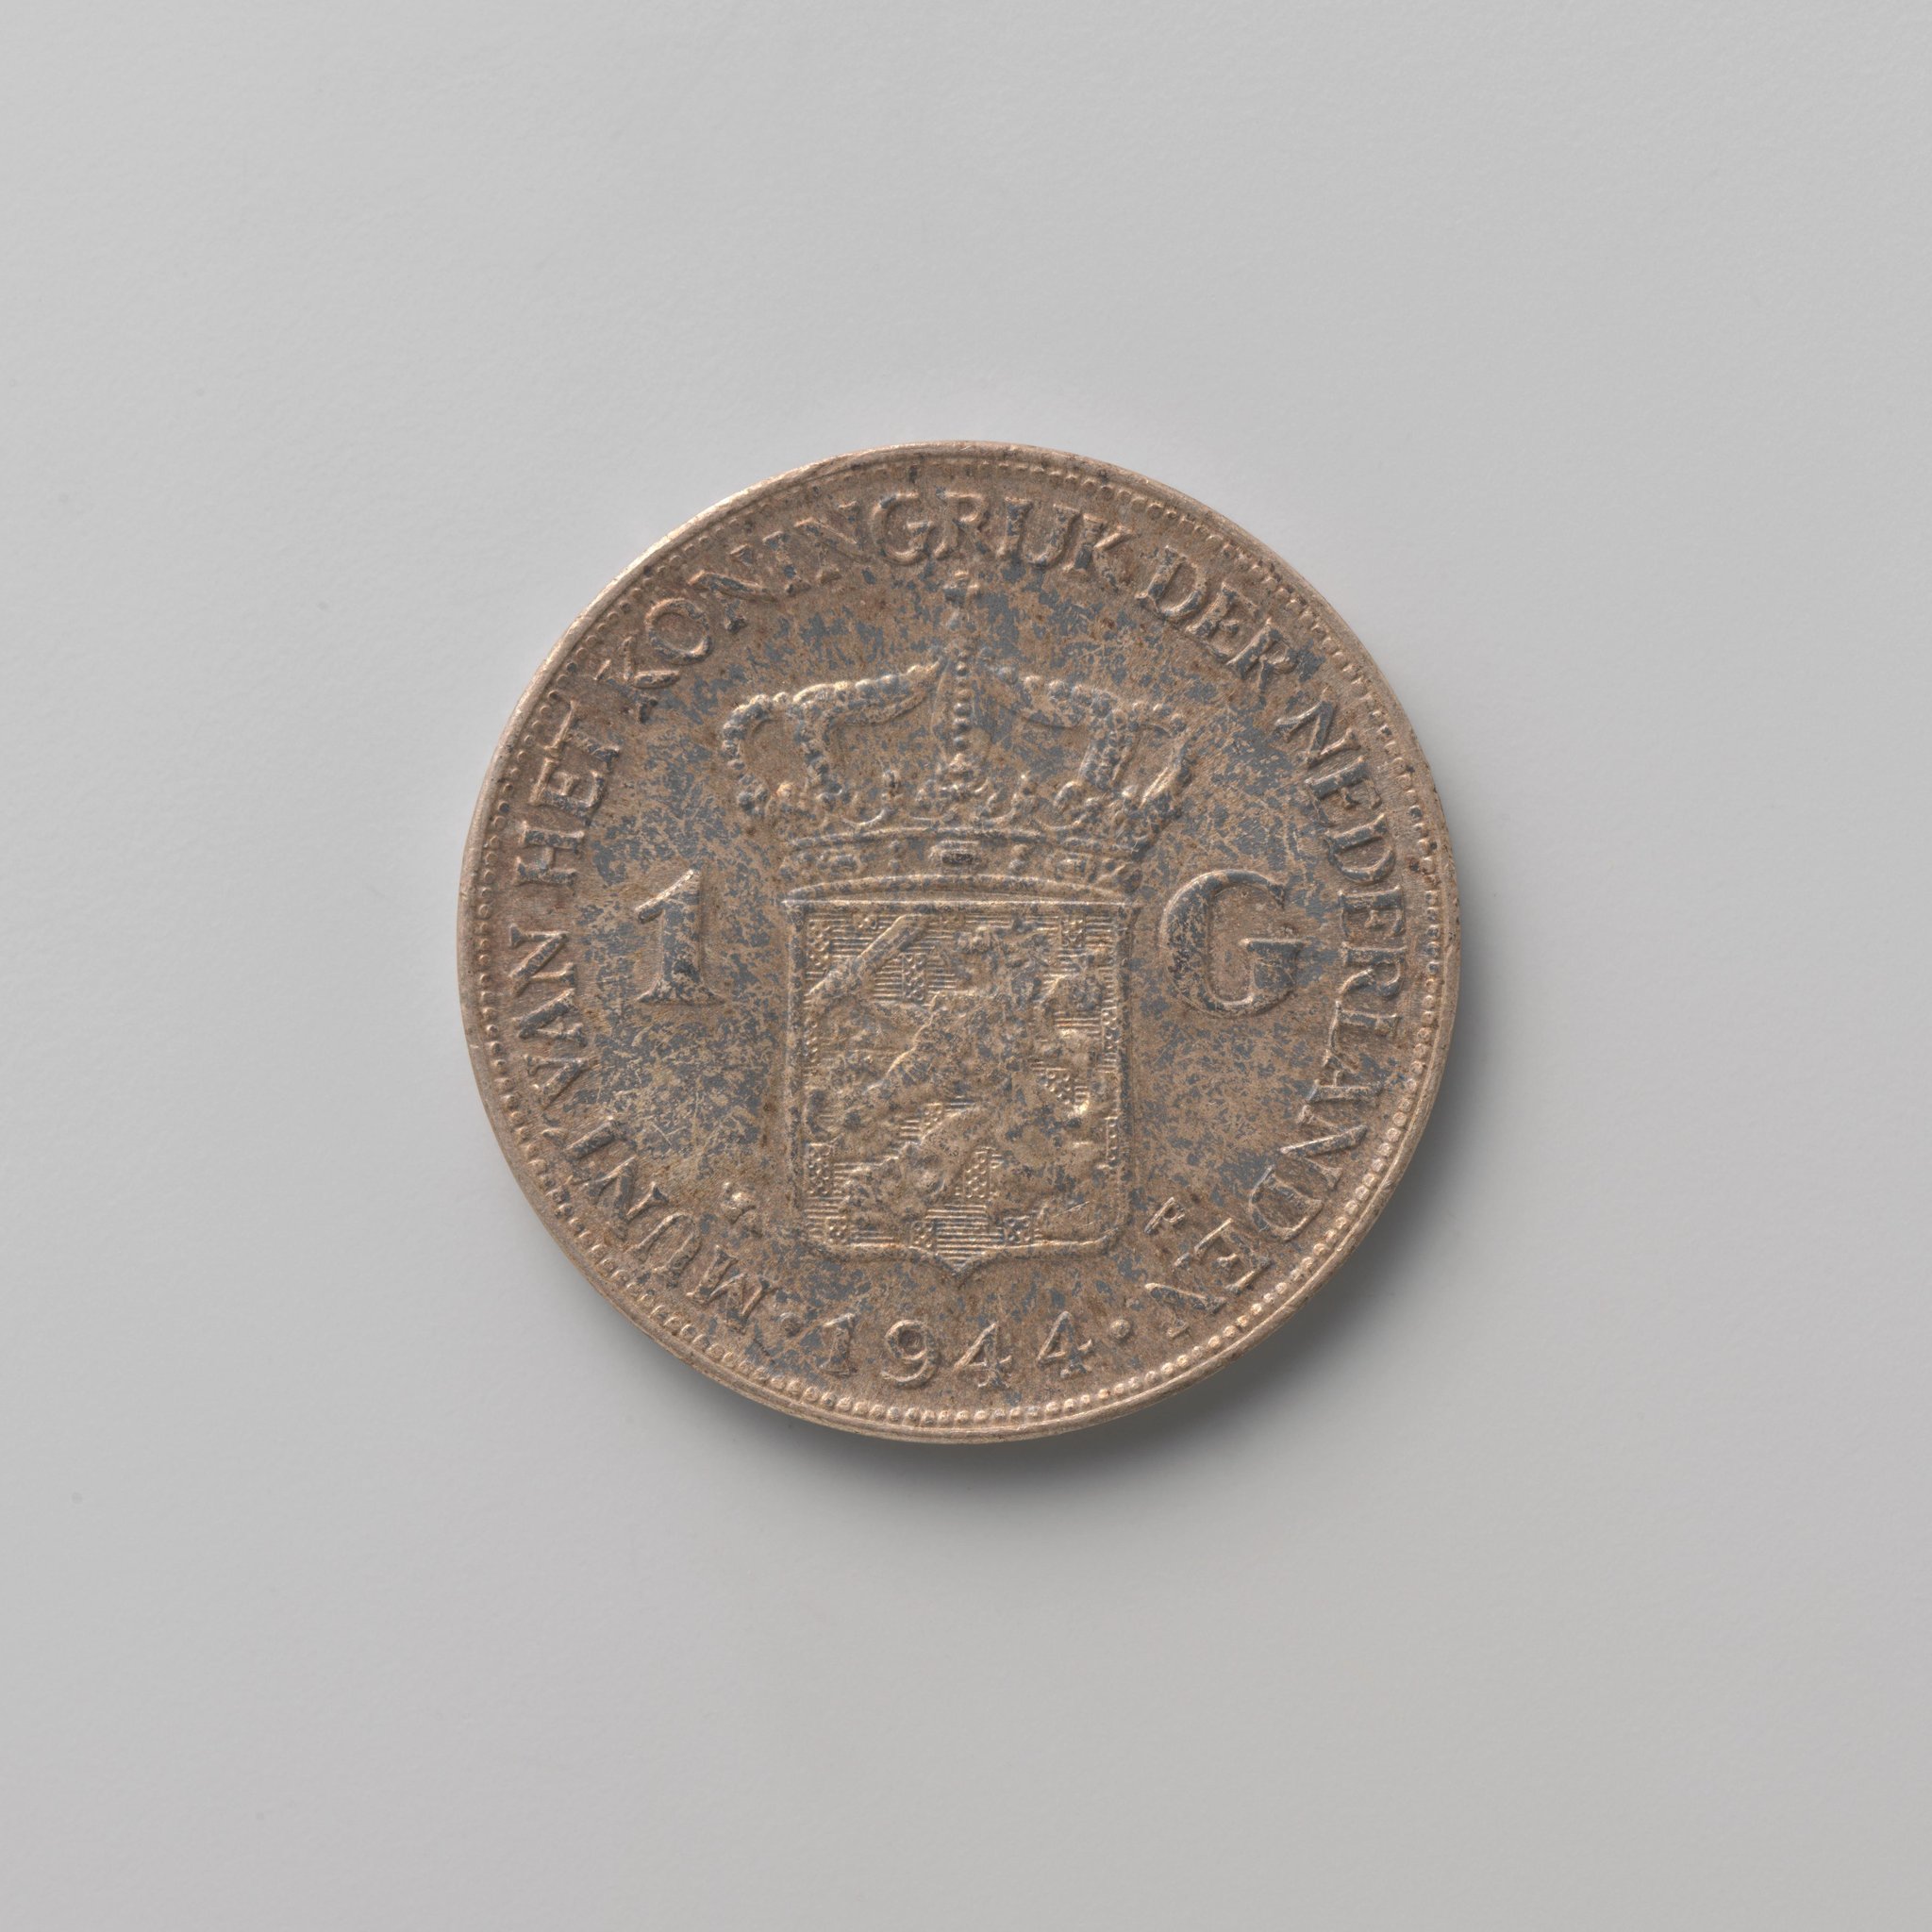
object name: coin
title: Nederlandse gulden,1944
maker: wilhelmina of the netherlands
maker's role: print maker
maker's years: 1880-1962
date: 1944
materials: silver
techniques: striking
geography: philadelphia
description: Zilveren munt. Voorzijde: hoofd naar links. Keerzijde: tussen waarde-aanduiding 1 G gekroond rijkswapenschild. Jaartal onderaan in omschrift. Onder wapenschild links: eikel en rechts: letter P [=Philadelphia]. Randschrift.